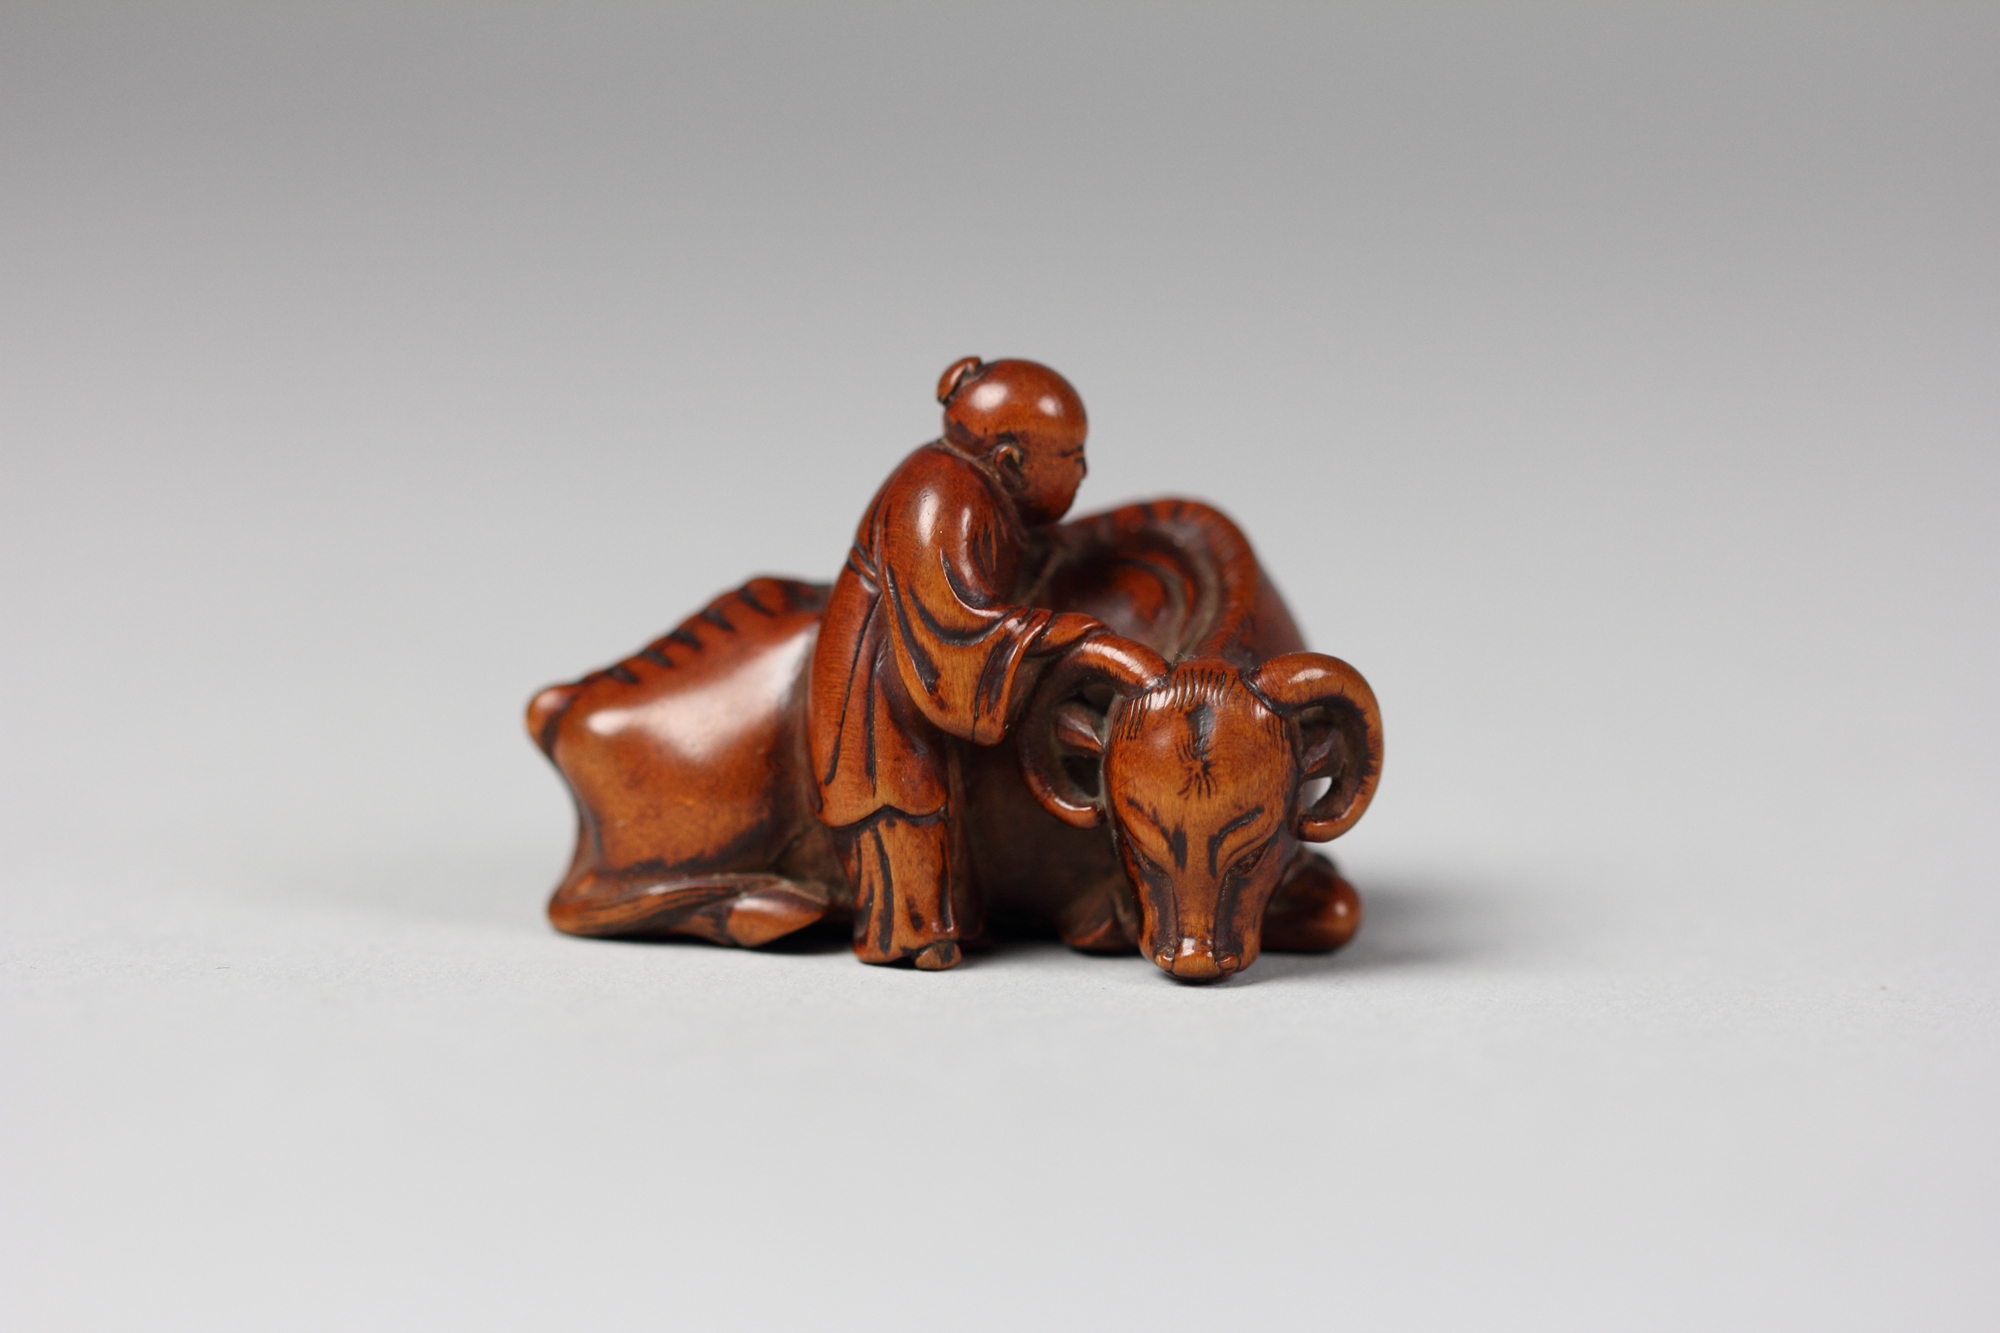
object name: netsuke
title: Netsuke of Ox and Herder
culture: japanese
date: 1701-1800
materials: wood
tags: animals,men